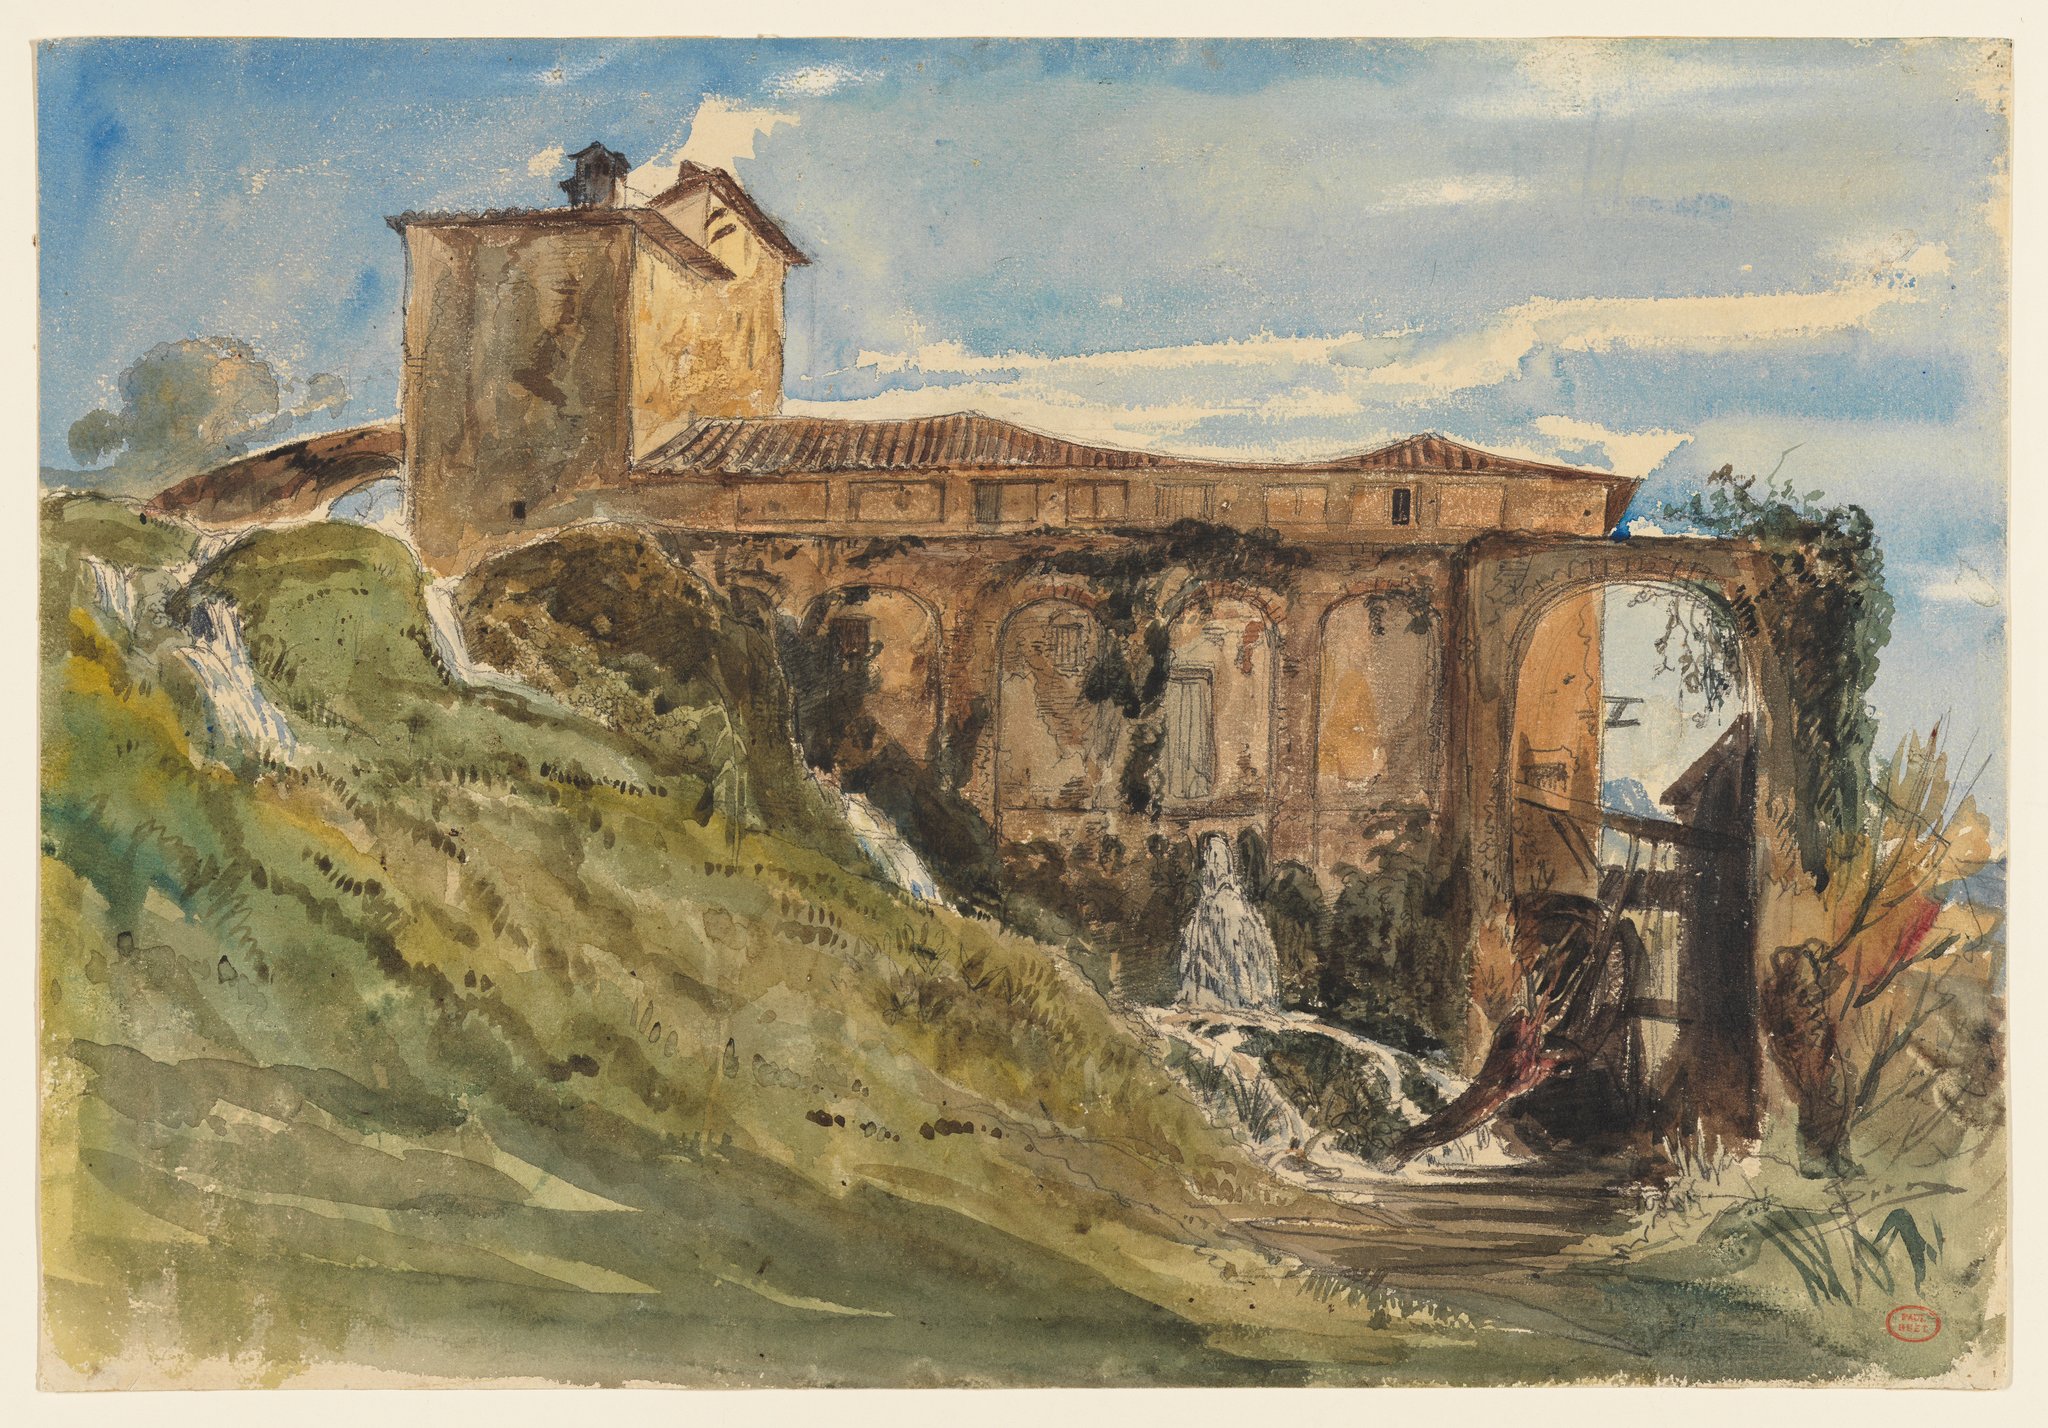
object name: drawing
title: A Villa near Rome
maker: paul huet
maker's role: artist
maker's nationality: french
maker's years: 1803-1869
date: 1841-1842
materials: graphite, watercolor